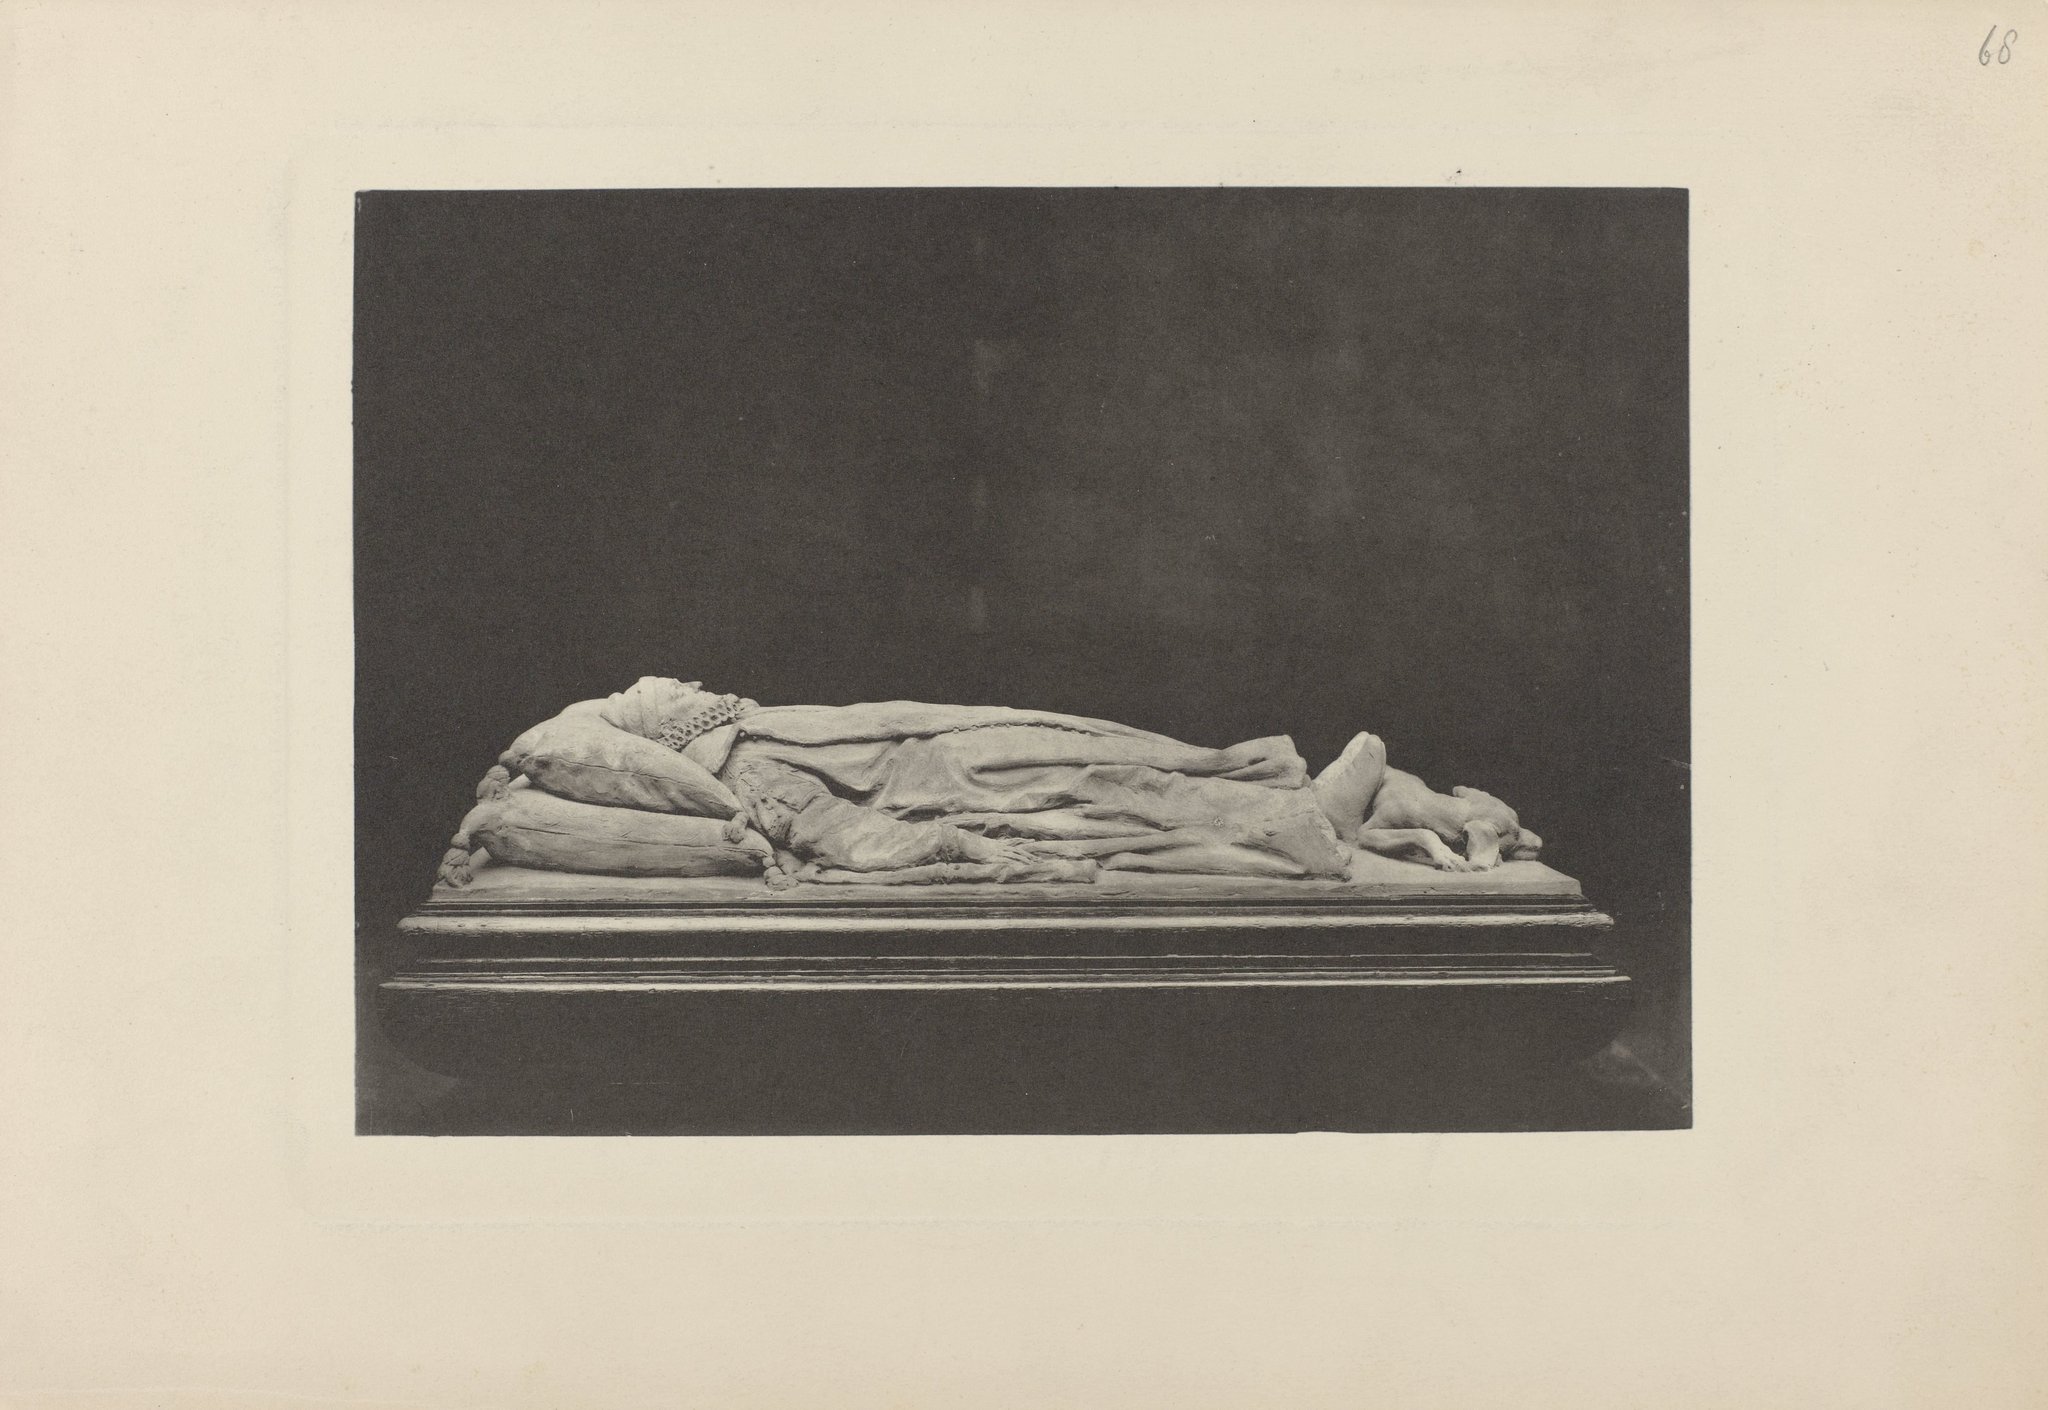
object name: photomechanical print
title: Graftombe van Willem I, prins van Oranje, 1623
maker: Anonymous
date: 1850-1949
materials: paper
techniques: photochemical processes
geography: netherlands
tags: delft, william i (prince of orange), grave-building, monumental tomb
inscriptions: collector's mark: Lugt 2228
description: De hier vermelde titel verwijst naar de hoogst verkregen titel van de geportretteerde, niet per se naar de titel die de geportretteerde op deze voorstelling draagt.